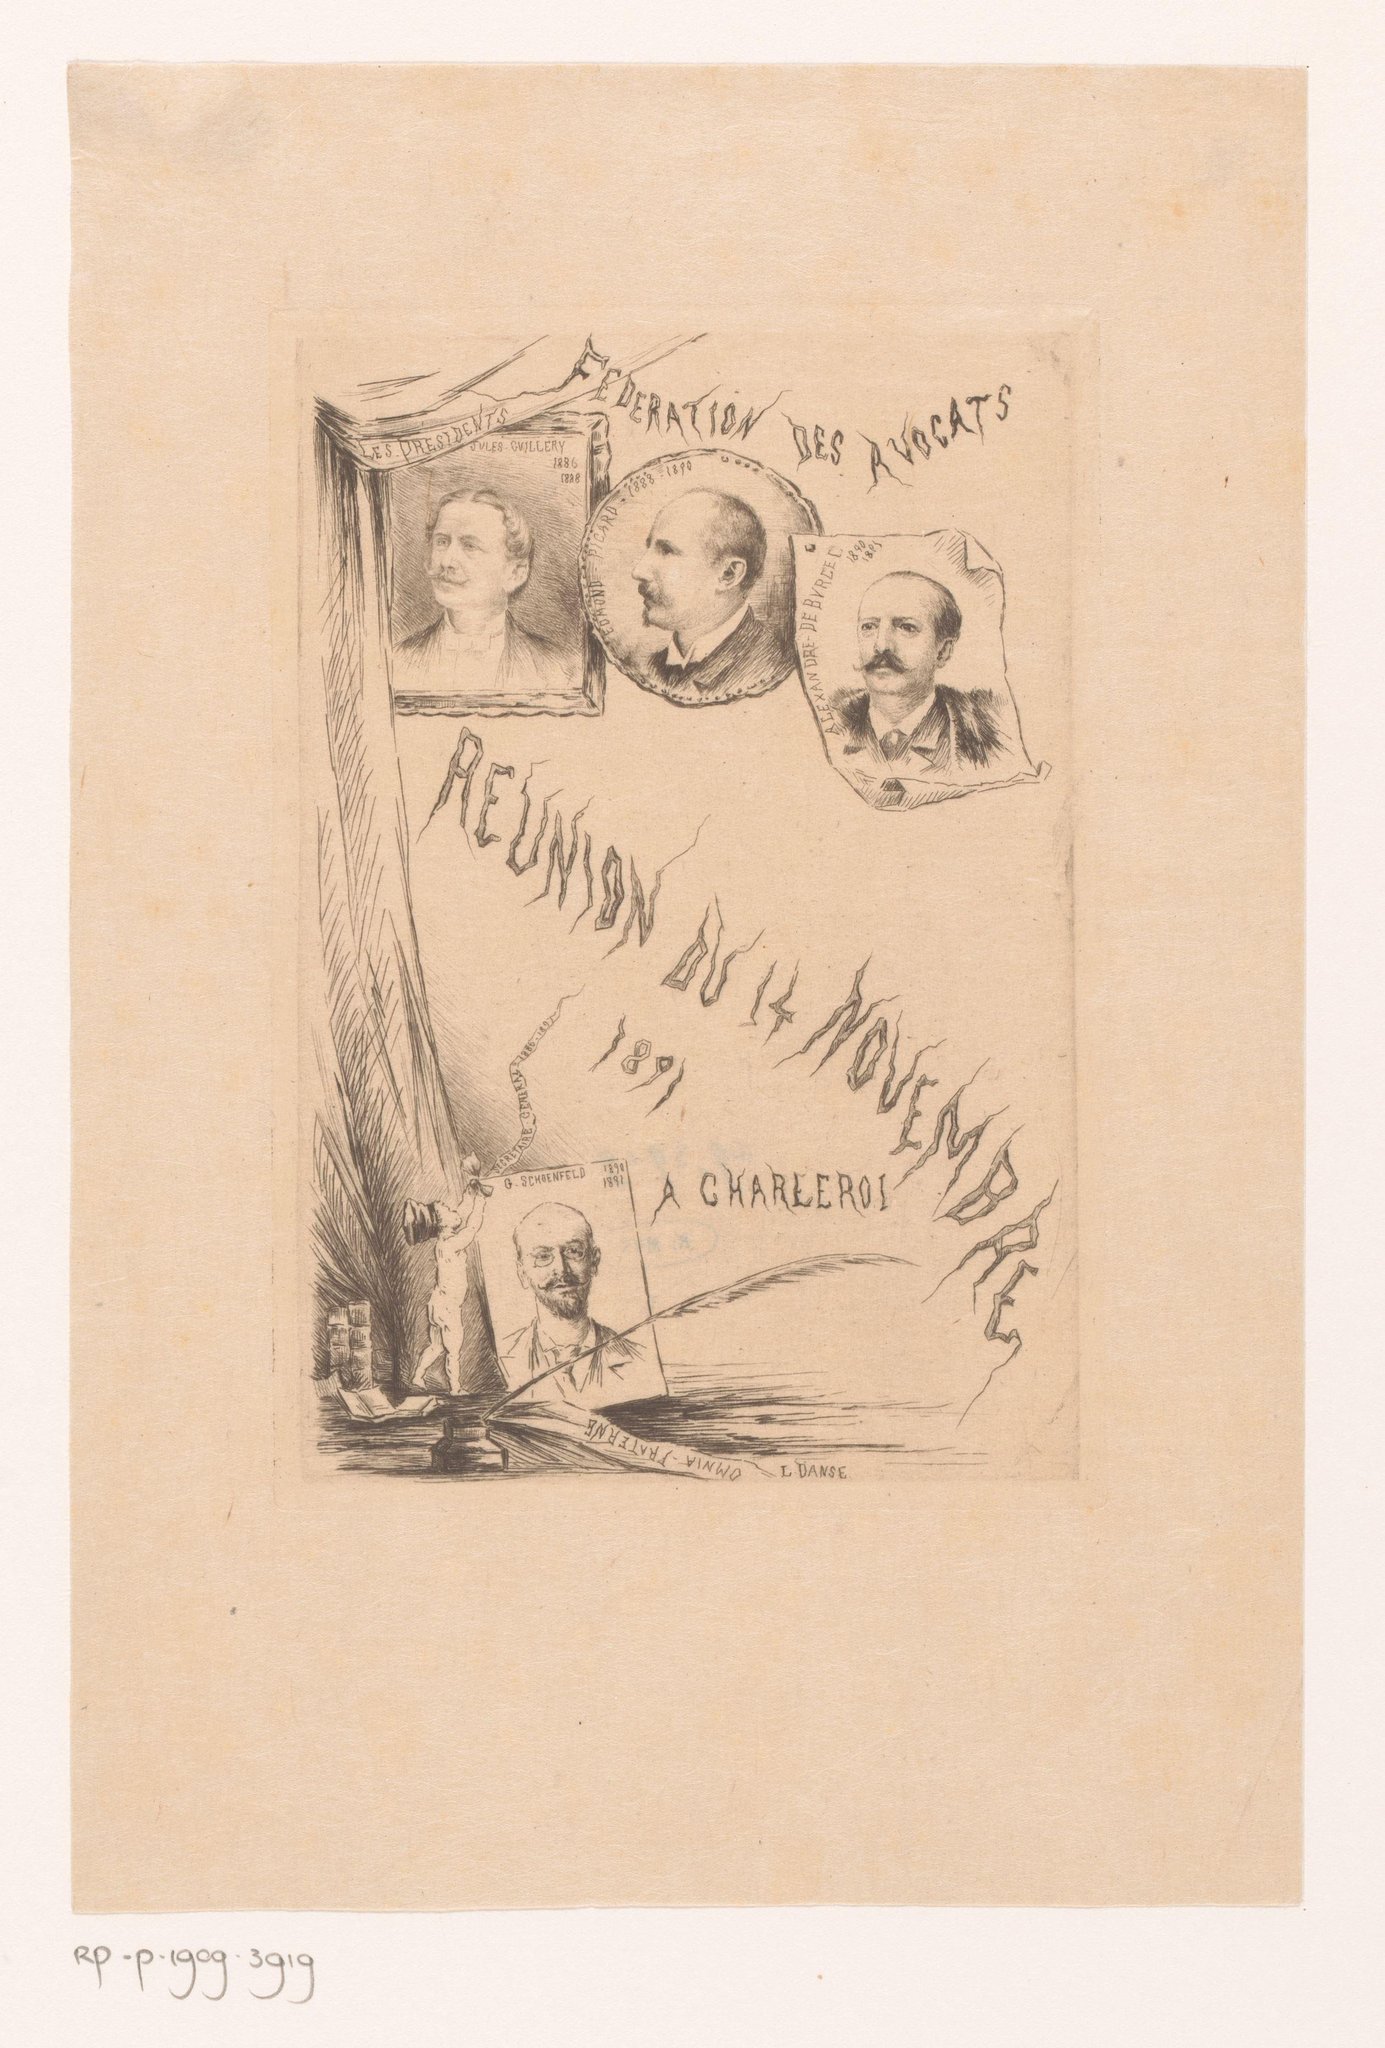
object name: print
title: Uitnodiging voor een bijeenkomst van de Federation des Avocats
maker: auguste danse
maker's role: print maker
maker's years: 1829-1929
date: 1891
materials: paper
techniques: etching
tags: nivelles, politician, brussels, edmond picard, lawyer, attorney at law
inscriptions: collector's mark: Lugt 2228